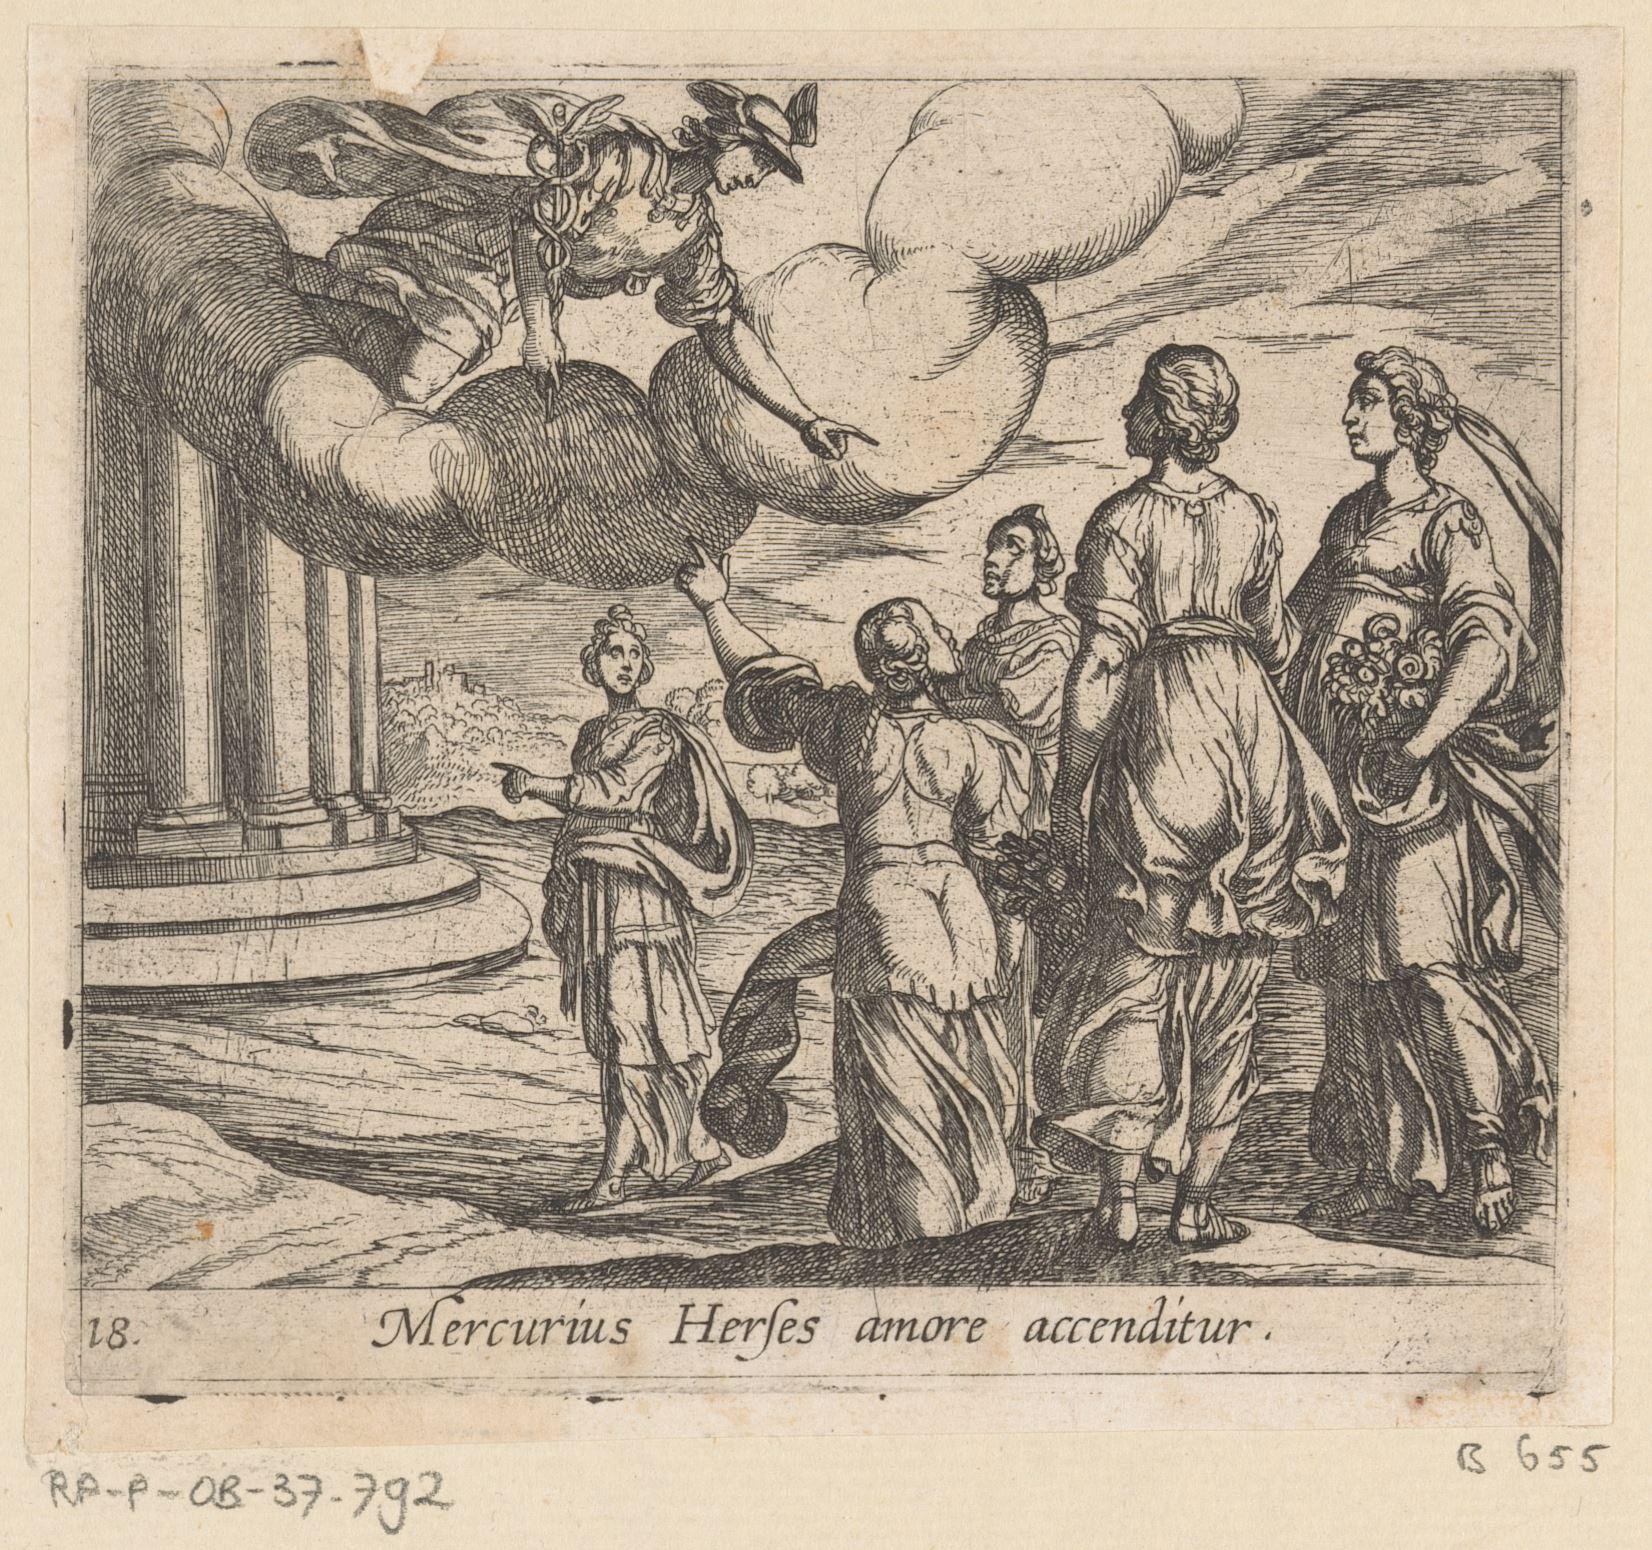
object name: print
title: Metamorphoseon sive transformationum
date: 1606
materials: paper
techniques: etching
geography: italy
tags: (story of) mercury (hermes)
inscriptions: collector's mark: Lugt 240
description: Mercurius, zwevend op wolken, wordt verliefd op Herse. Herse loopt samen met haar metgezellinnen naar de tempel met vers geplukte bloemen. Titel in het Latijn in ondermarge.